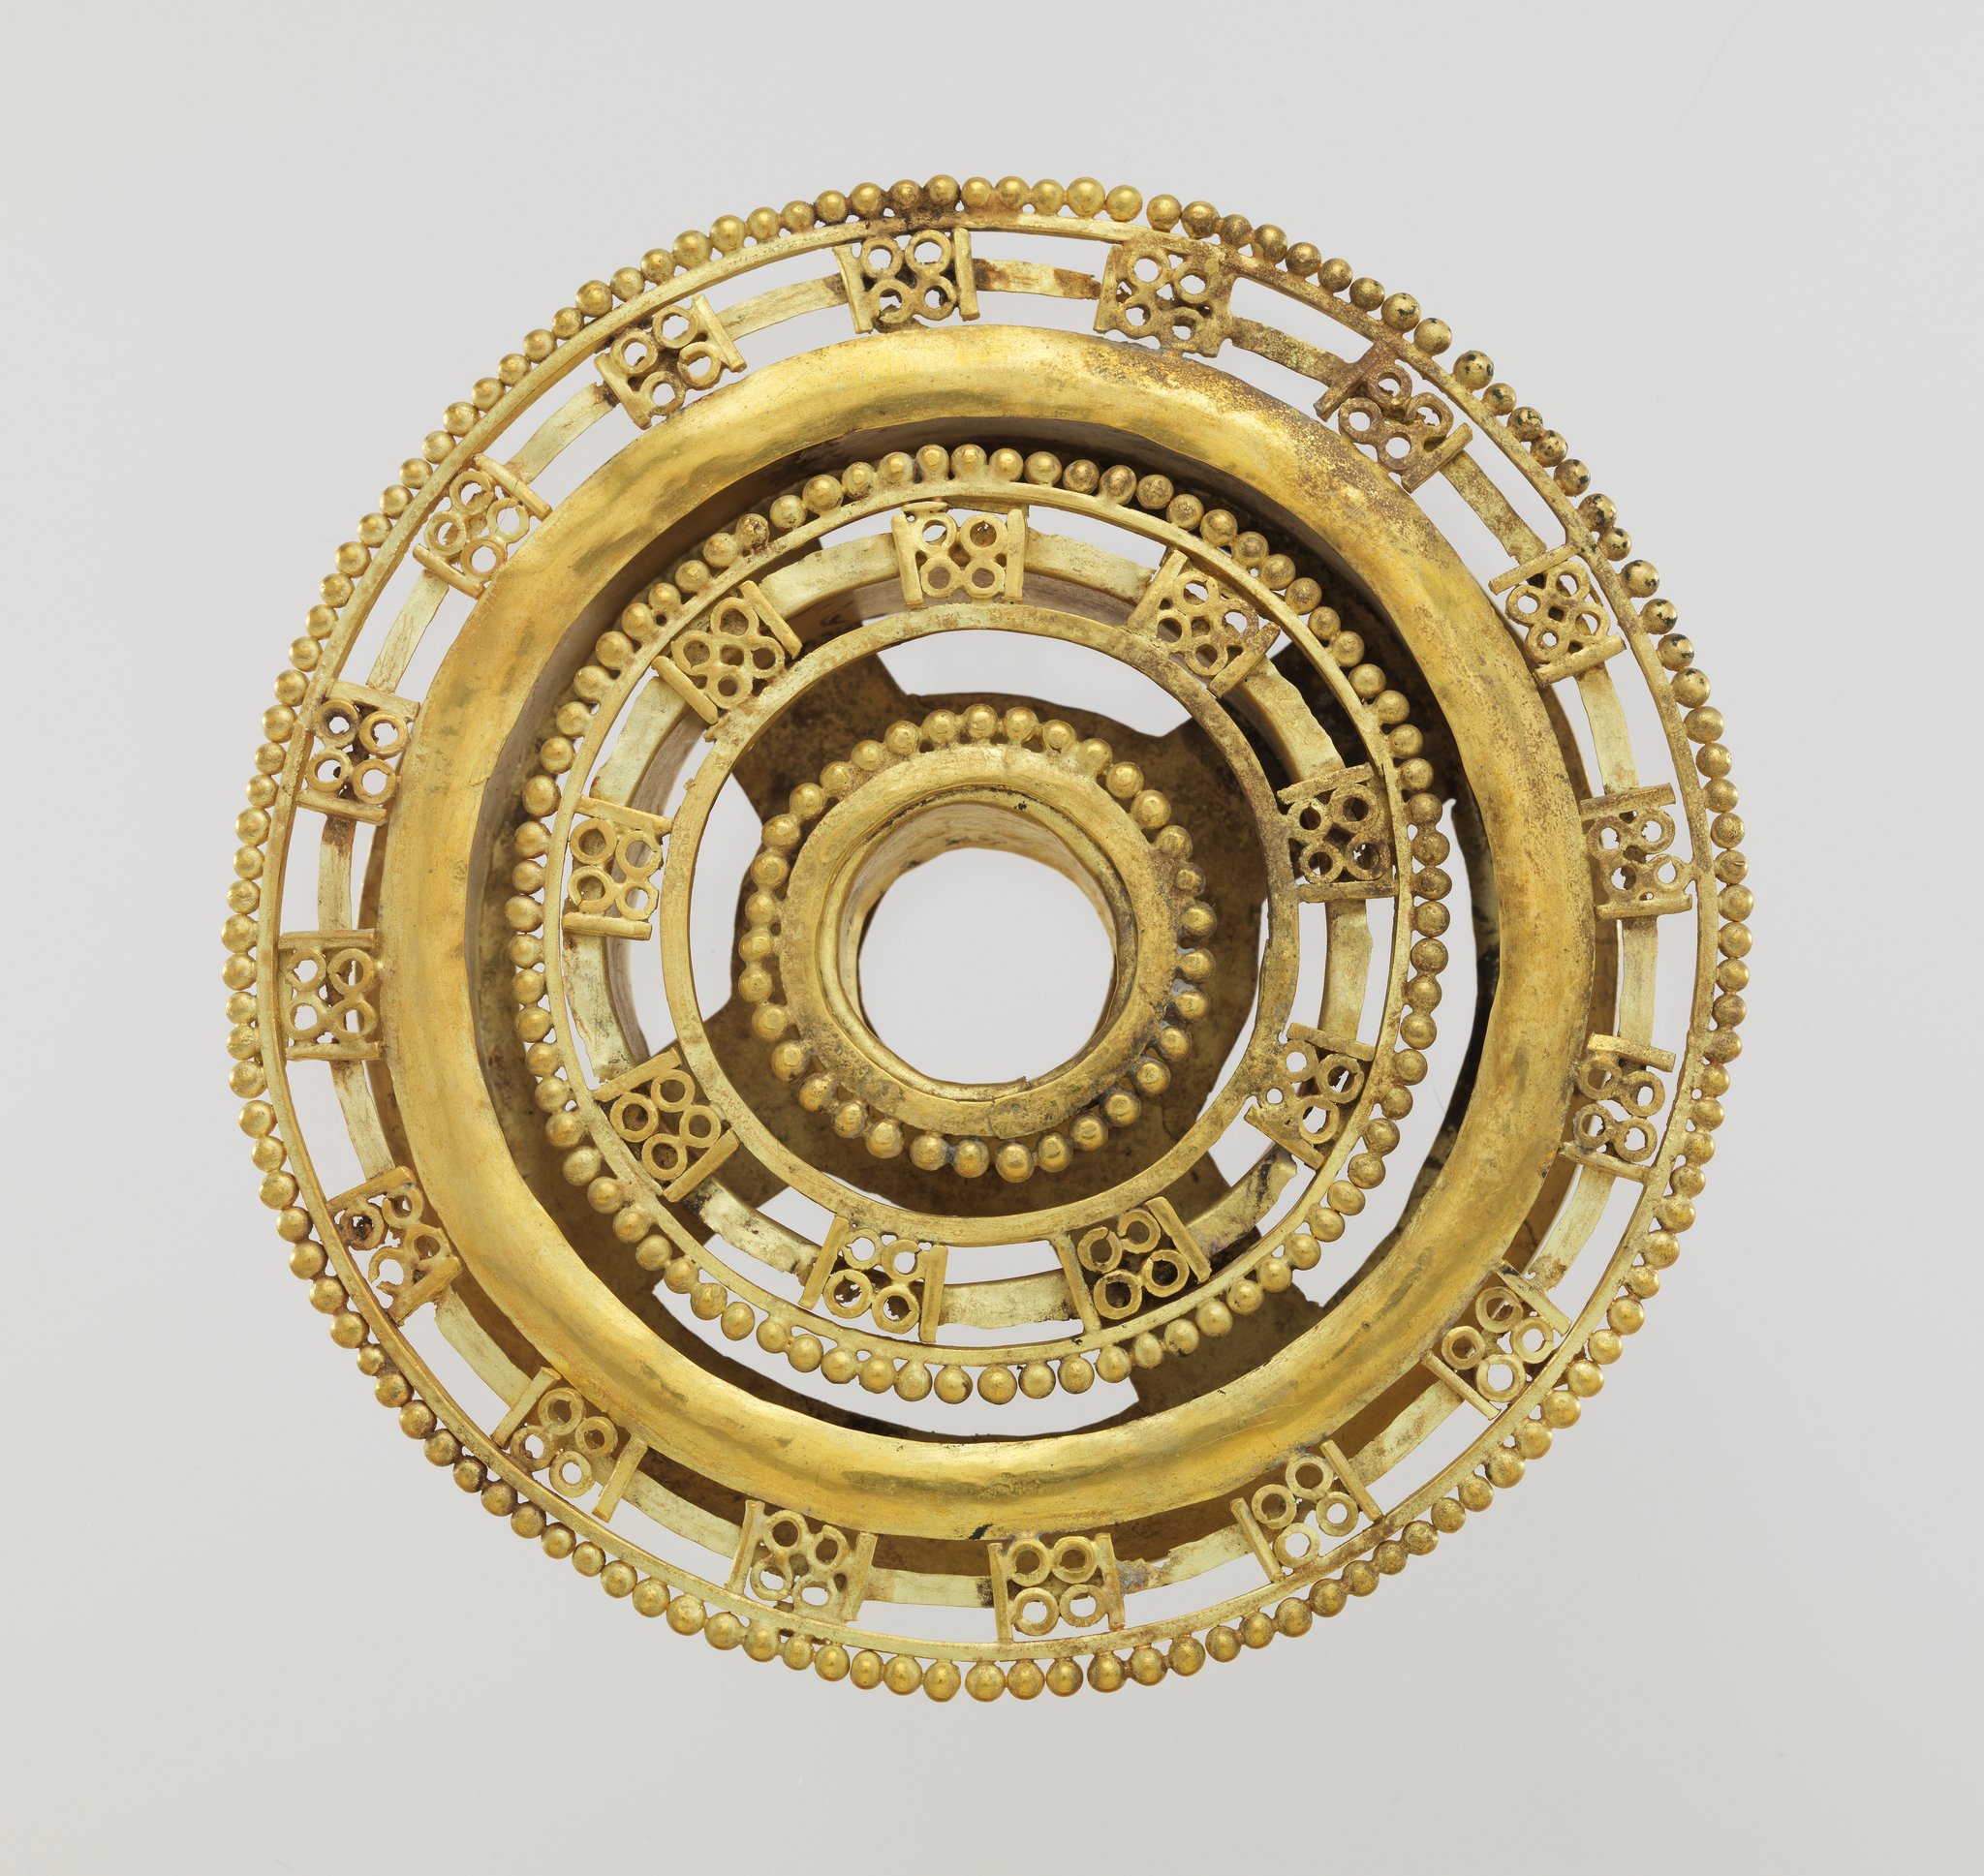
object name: earflare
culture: lambayeque, sicán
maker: lambayeque (sicán) artist(s)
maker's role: artist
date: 900-1100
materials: gold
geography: peru